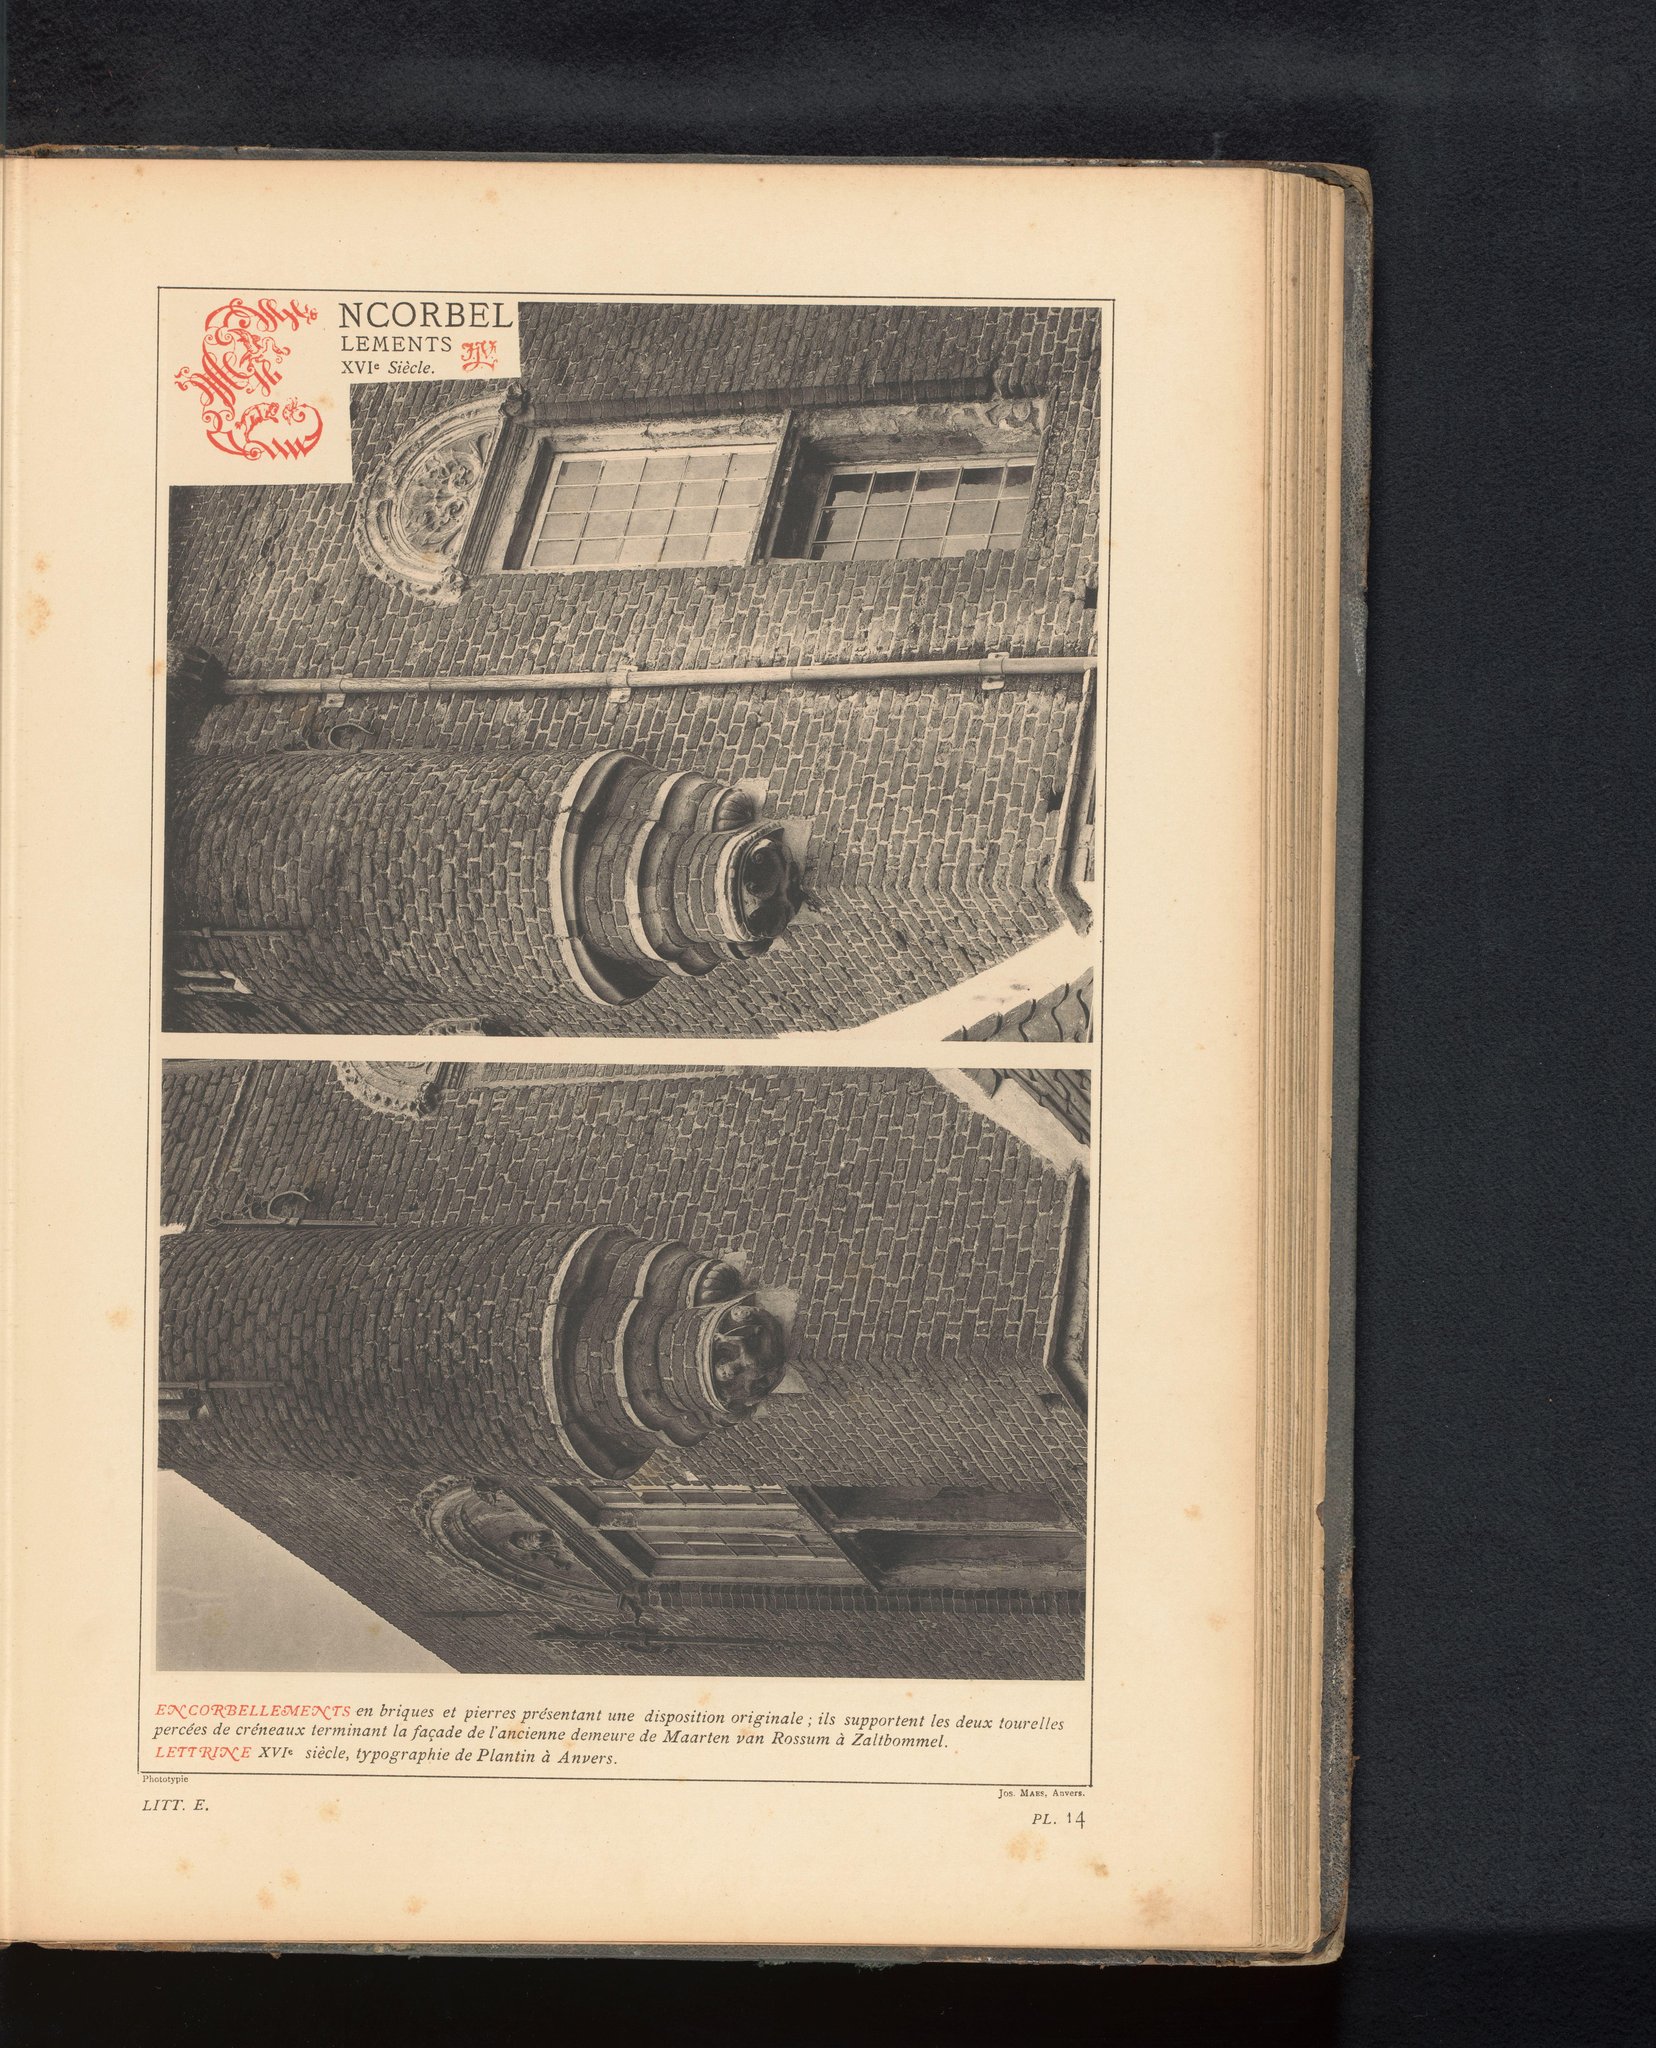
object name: photomechanical print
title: Twee kraagstenen aan de voorzijde van het Maarten van Rossumhuis in Zaltbommel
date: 1875-1880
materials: paper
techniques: photograph, photolithography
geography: zaltbommel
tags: architectural detail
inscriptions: monogram: ‘JJvY’, inscription: ‘ENCORBELLEMENTS en briques (...)’, inscription: ‘LITT. E. - PL. 14’